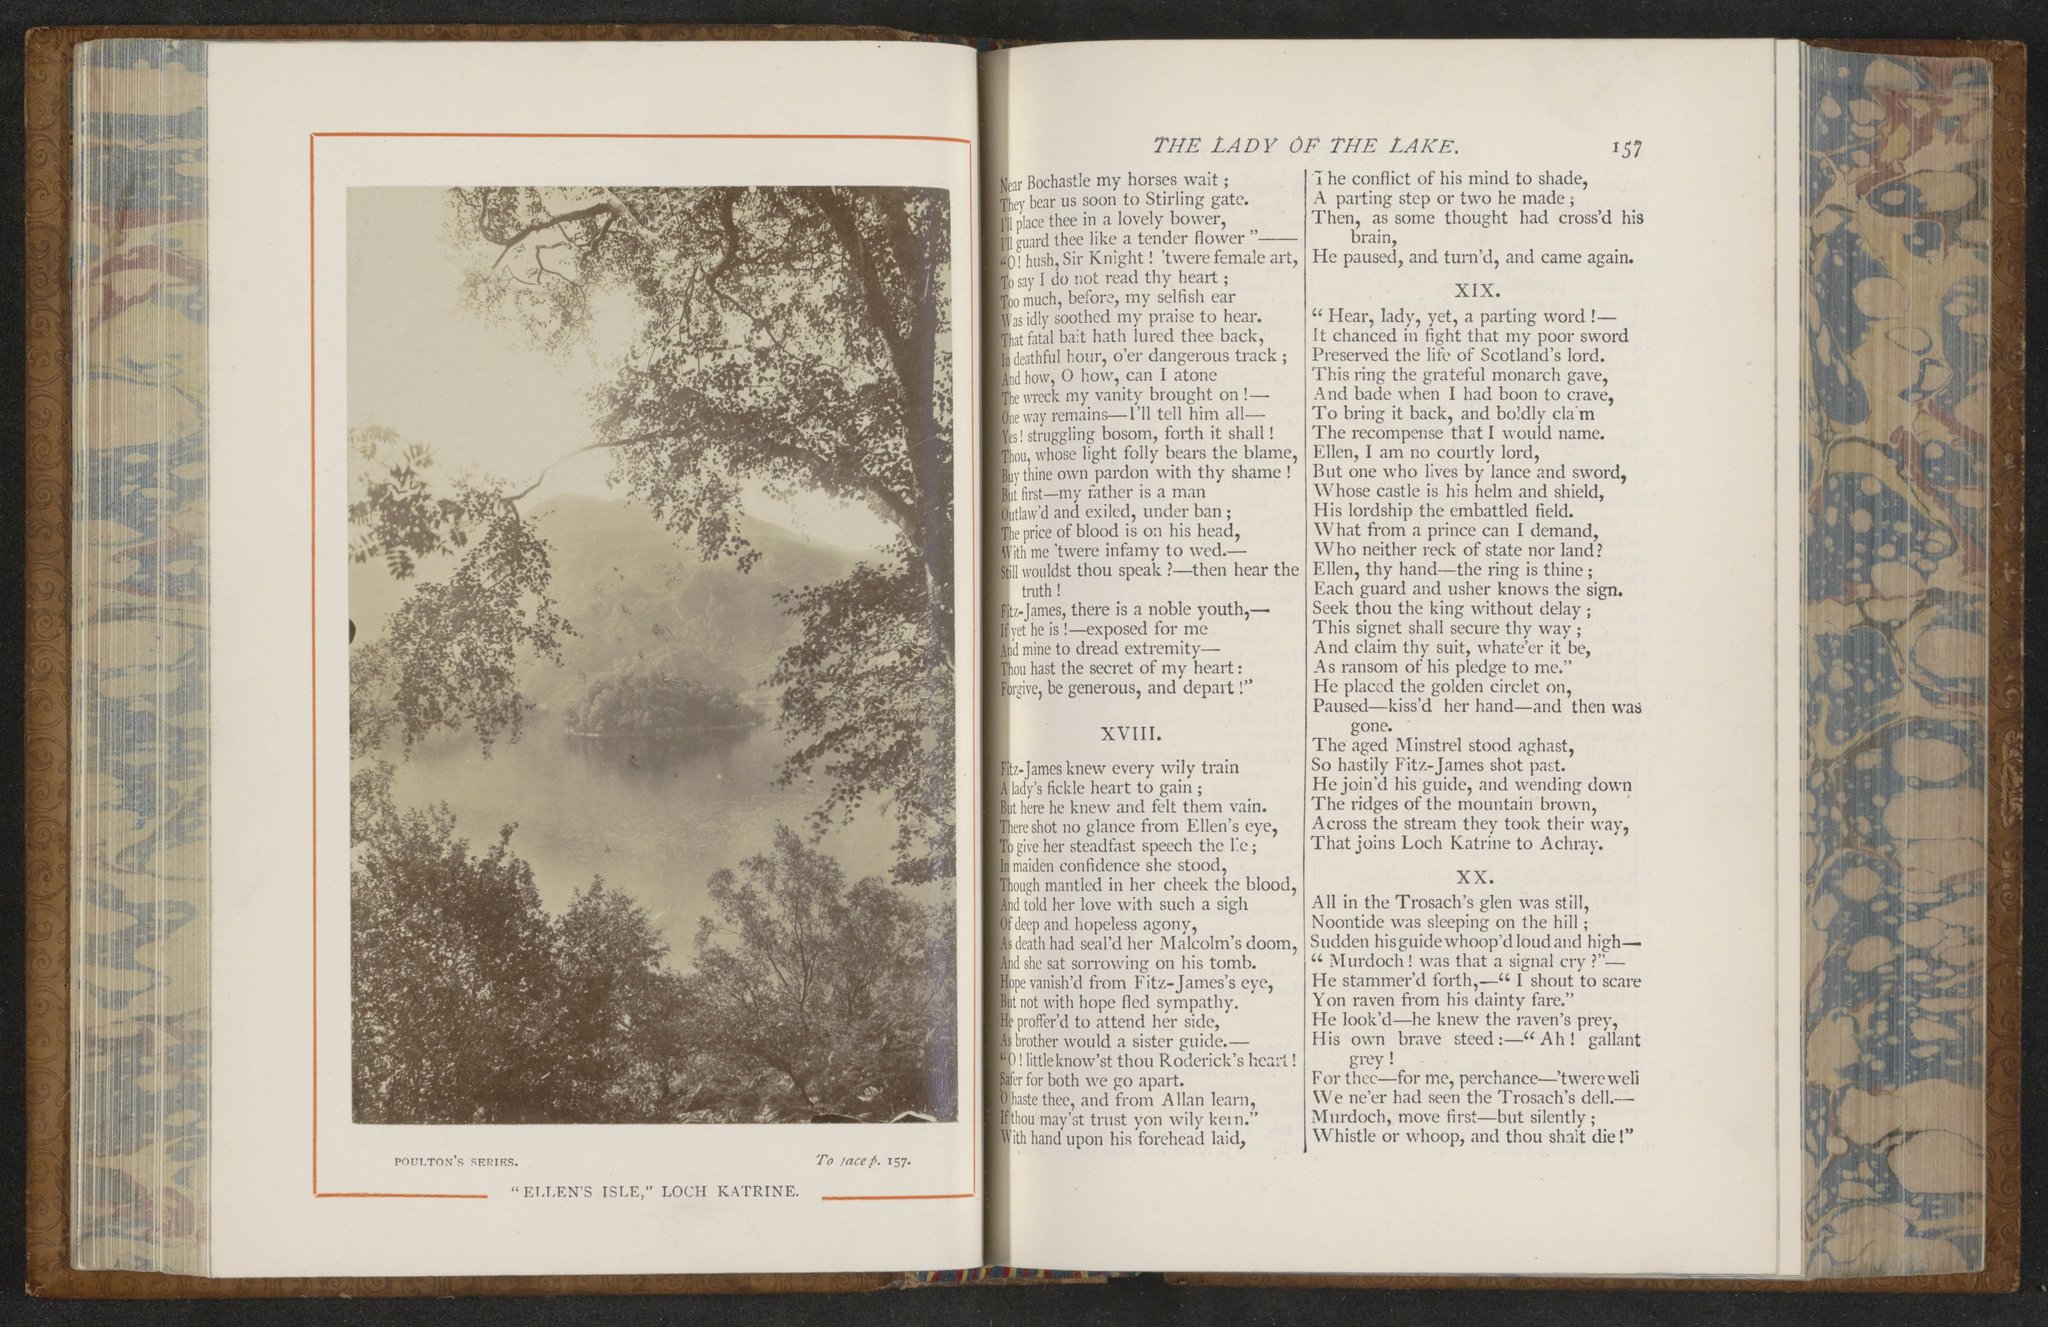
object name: page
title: Gezicht op Ellen's Isle in Loch Katrine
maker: Anonymous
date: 1880-1890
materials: photographic support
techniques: albumen print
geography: loch katrine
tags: island, lake - hh - ideal landscapes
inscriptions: inscription: ‘Poulton's series.’